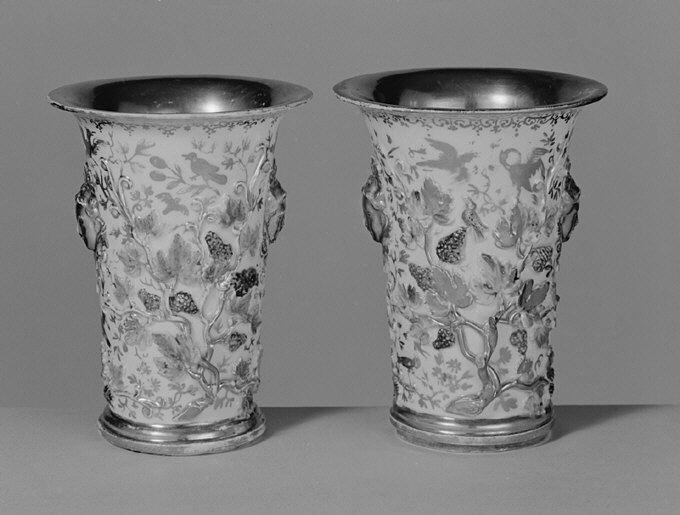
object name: beaker vase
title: Pair of beaker vases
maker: meissen manufactory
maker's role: manufactory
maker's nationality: german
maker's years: 1710-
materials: hard paste porcelain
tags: grapes